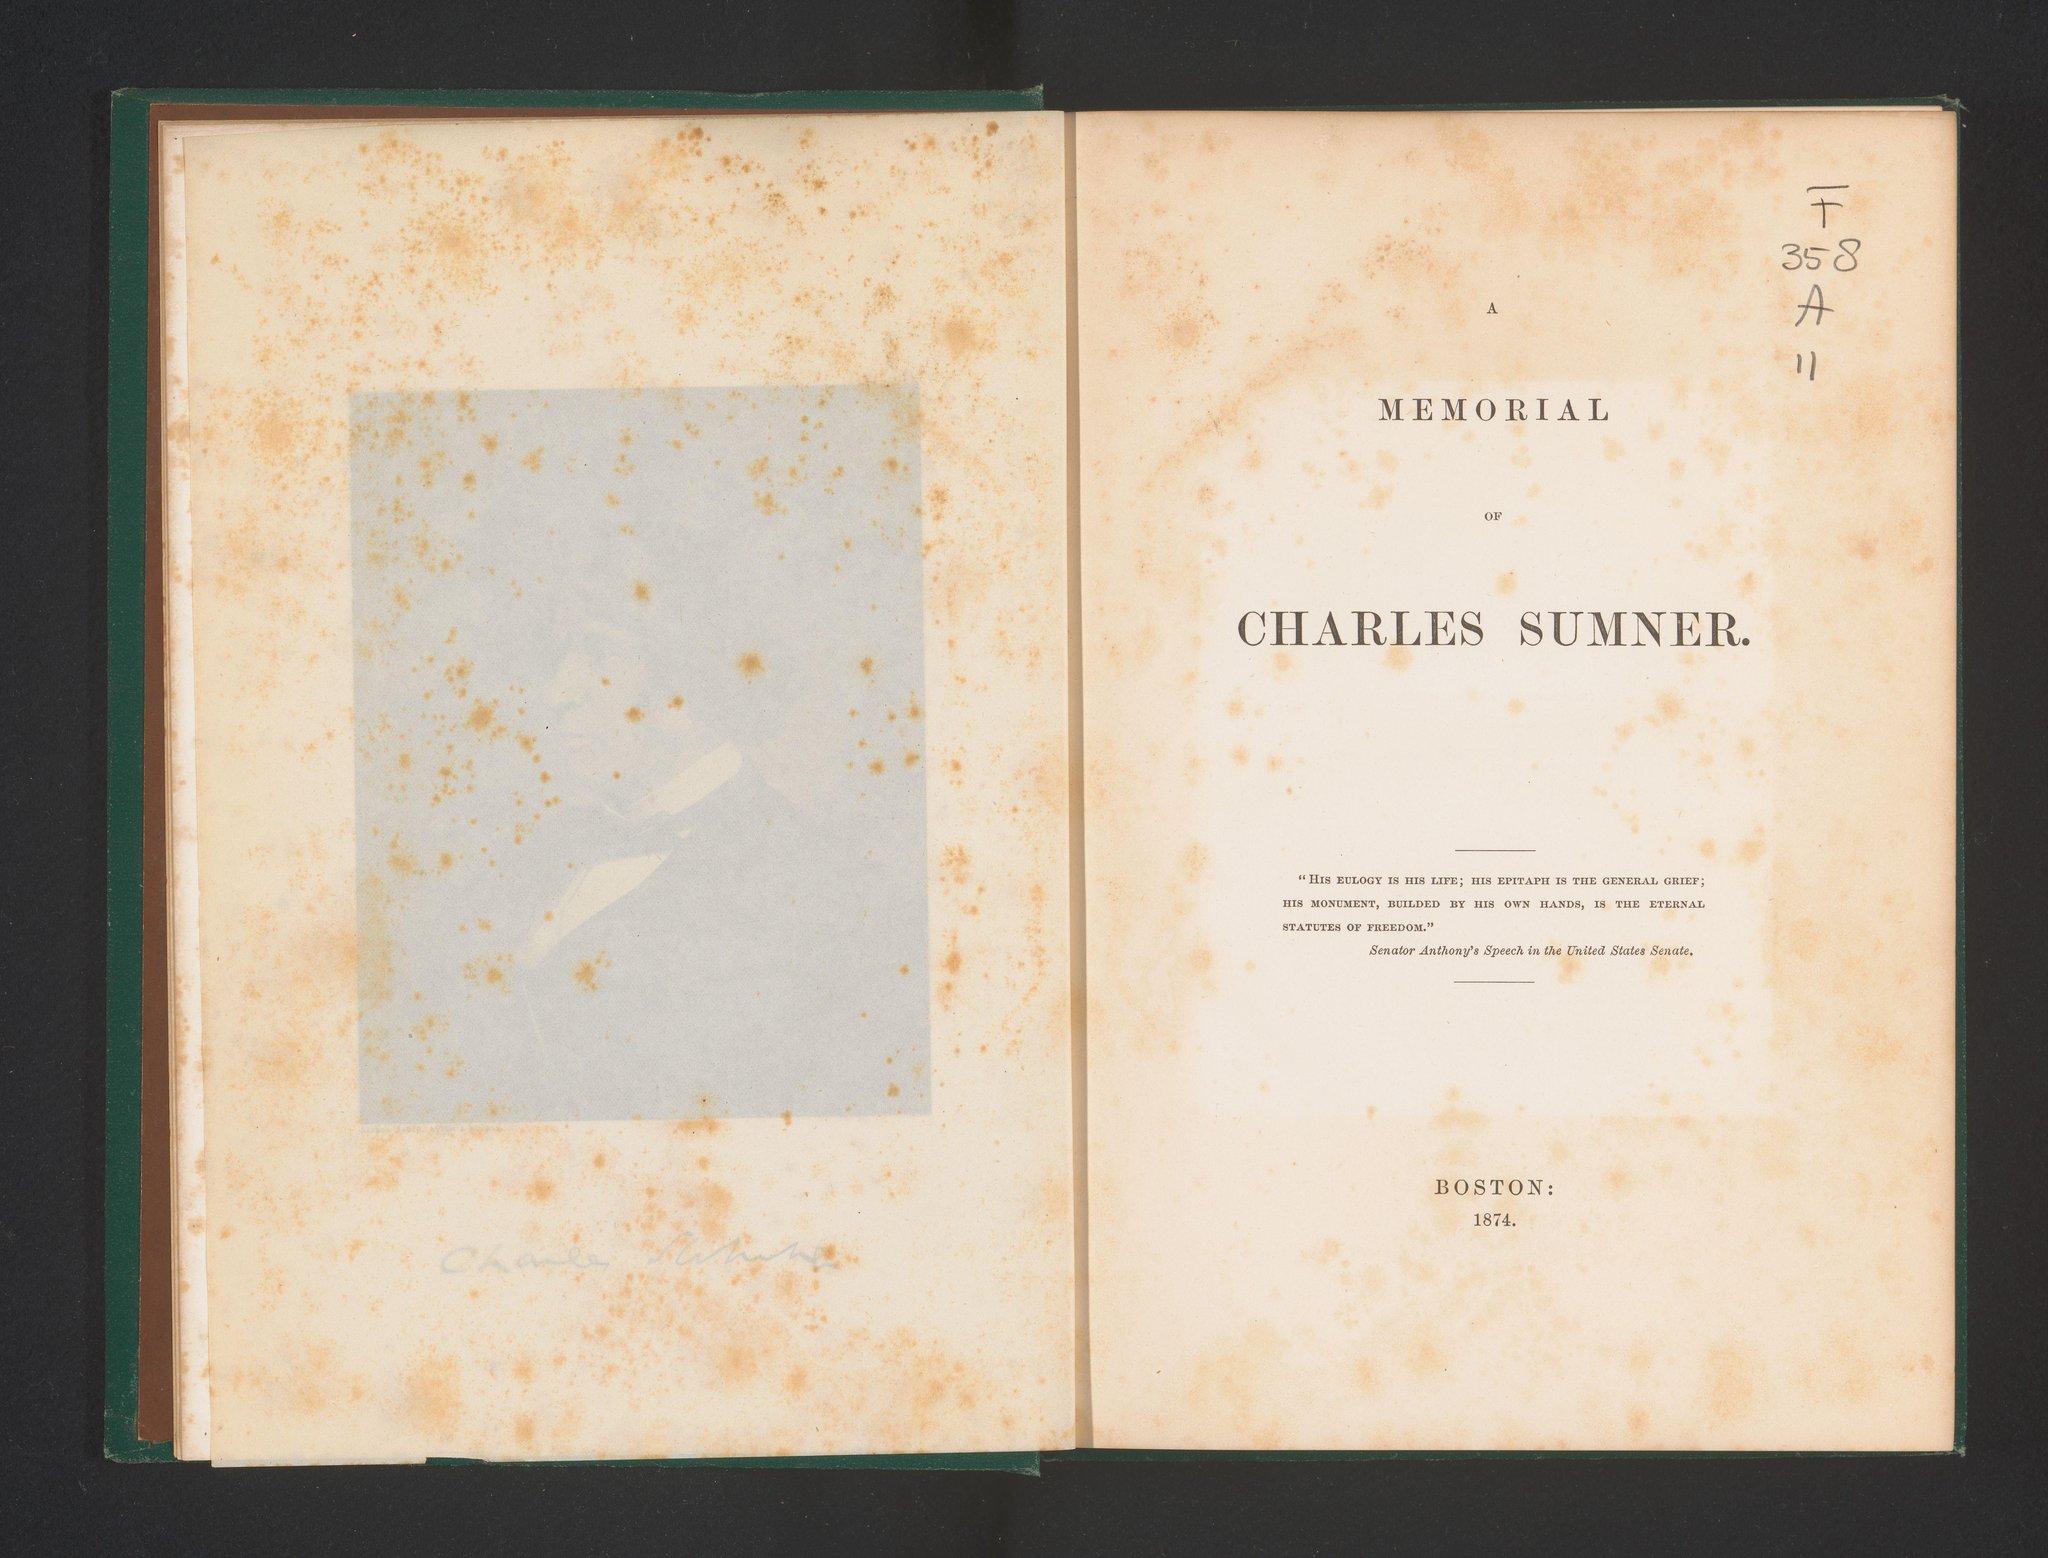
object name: book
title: A memorial of Charles Summer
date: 1874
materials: cardboard, paper, textile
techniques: carbon print, printing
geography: boston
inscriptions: annotation: ‘APR/1984’, bookplate: ‘Presented to/ Peterborough Town Library/ Peterborough, N.H./ George S. Gates/ Groton. Mass./ Date June 19, 1899’, bookplate: ‘Town Library/ established 1833./ Abbreviated Regulations/ (...)’